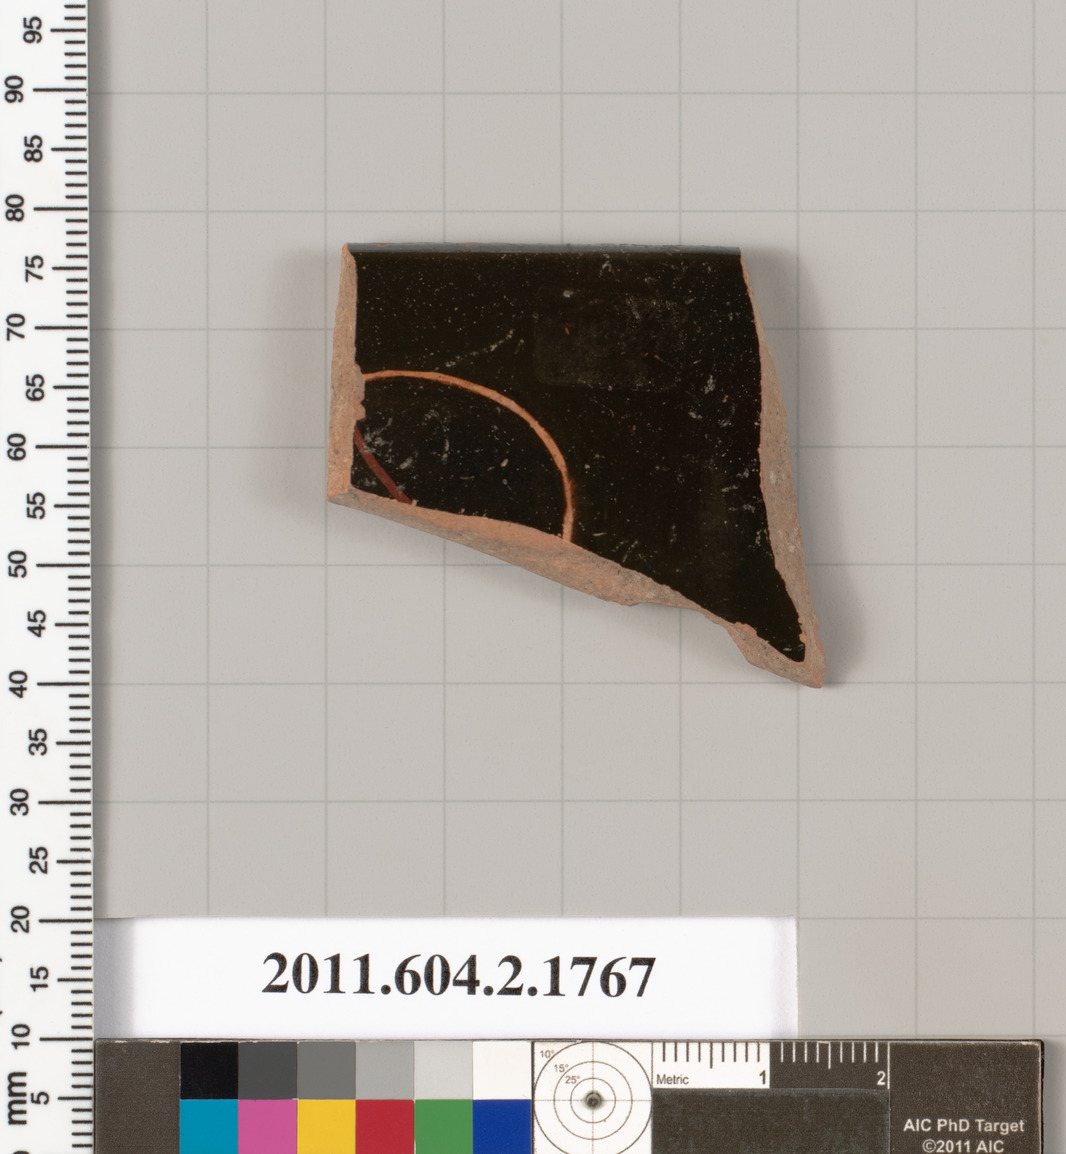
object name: skyphos fragment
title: Terracotta rim fragment of a skyphos (deep drinking cup)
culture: greek, attic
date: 475-451 BCE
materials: terracotta